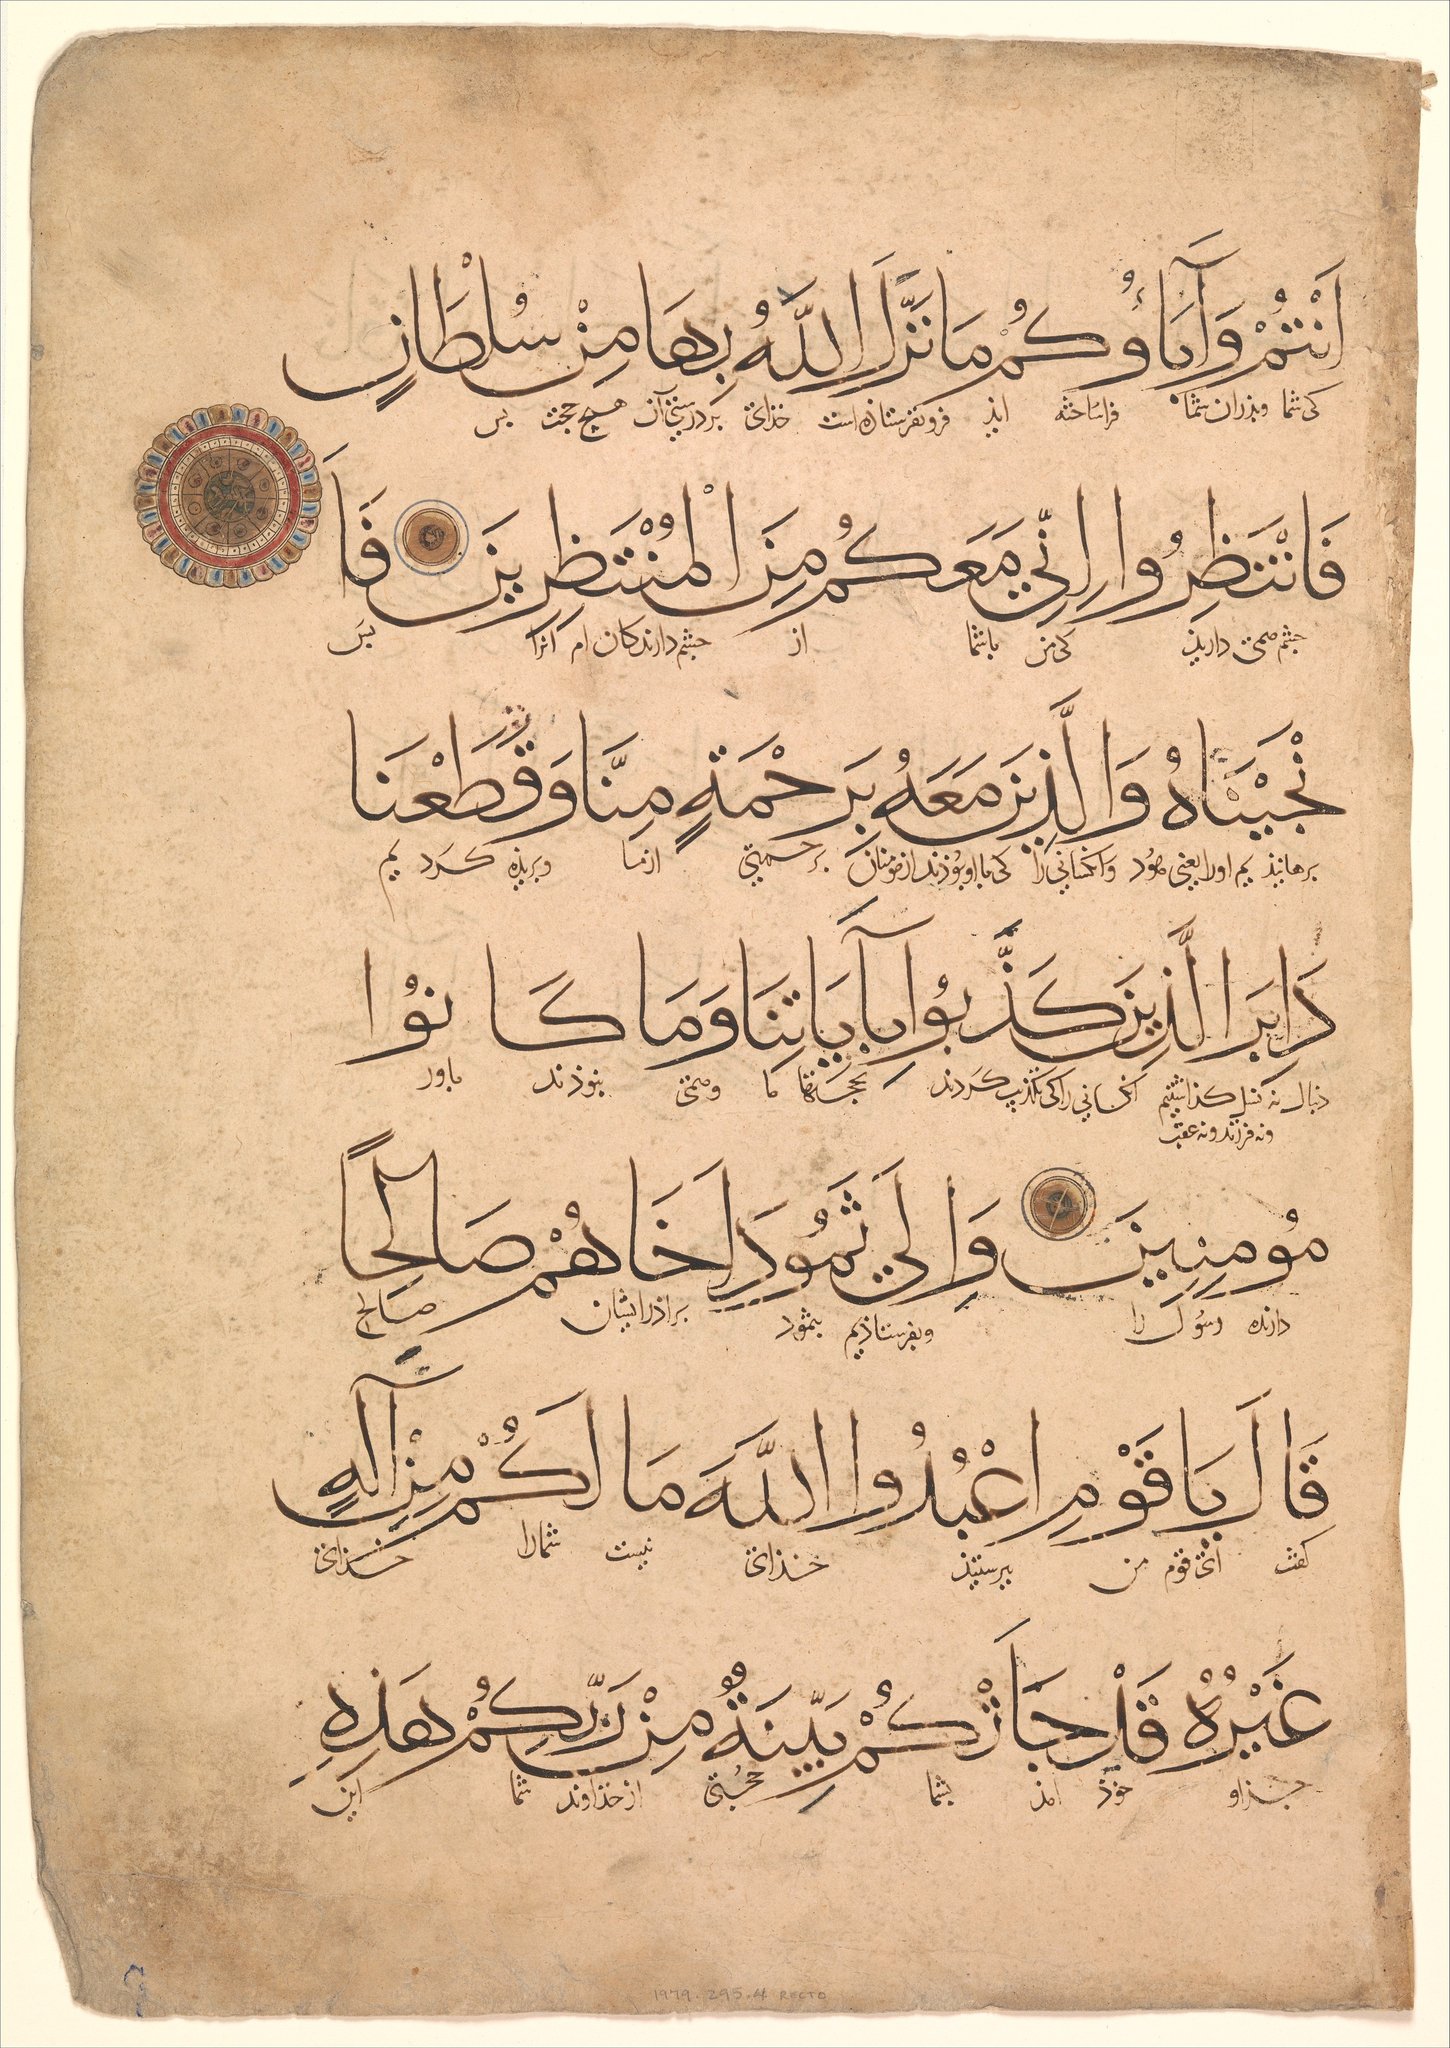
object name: folio from a non illustrated manuscript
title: Folio from a Qur'an Manuscript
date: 1301-1400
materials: gold, ink, paper, watercolor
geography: india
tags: qur'an,calligraphy